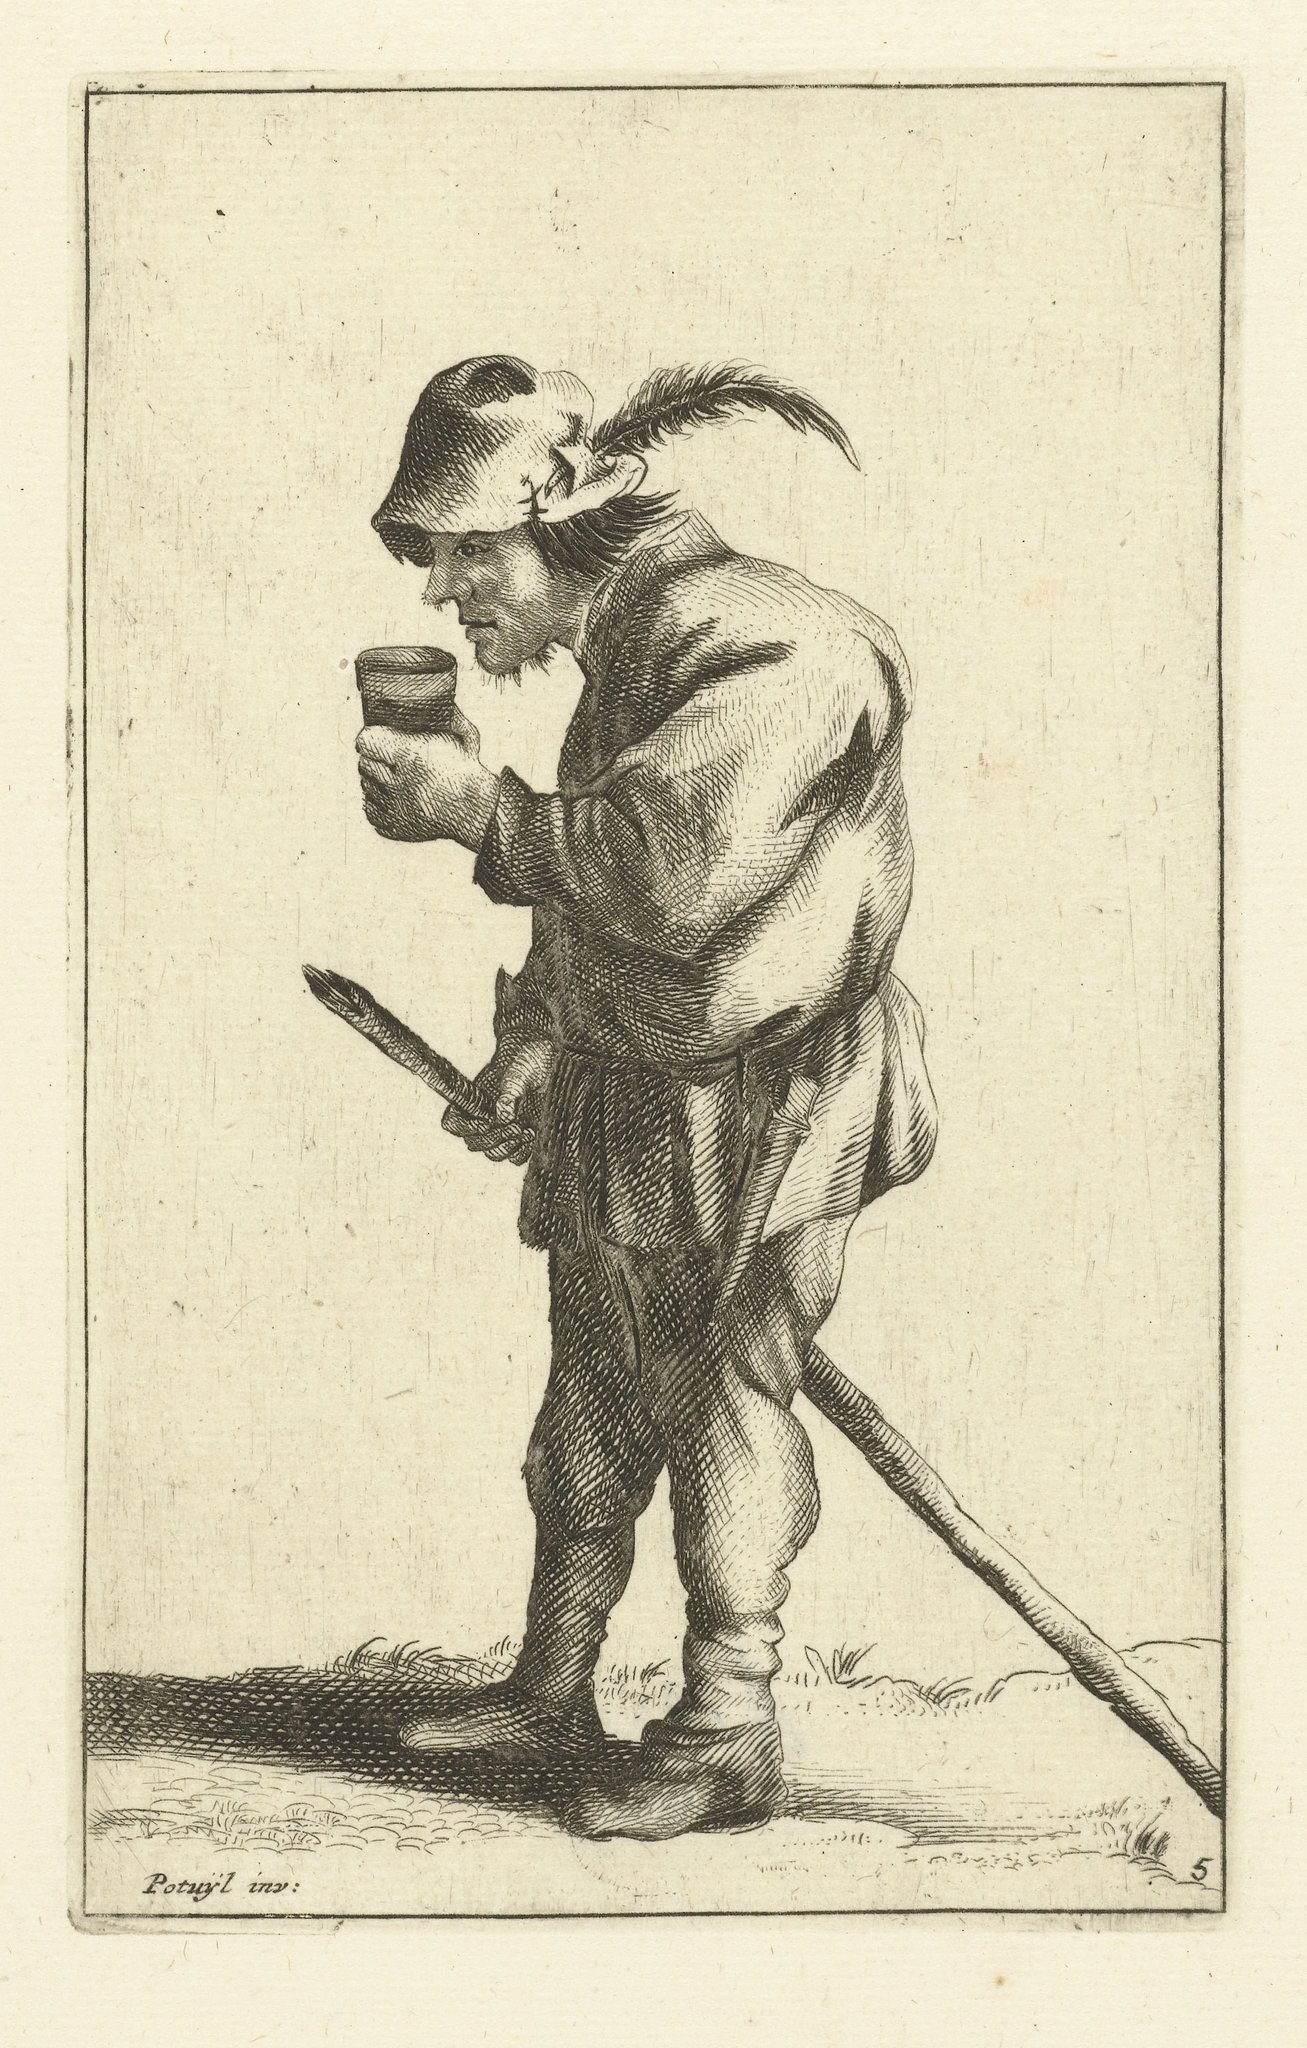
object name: print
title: Boer met glas in de hand en stok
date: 1613-1656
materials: paper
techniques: etching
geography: netherlands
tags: farmers, glass, rummer, drinking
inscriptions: collector's mark: Lugt 2228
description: Prent uit serie van zes prenten met boeren naar verschillende kunstenaars: Jan Miense Molenaer, Pieter Quast, Hendrik Potuyl en Adriaen van Ostade.